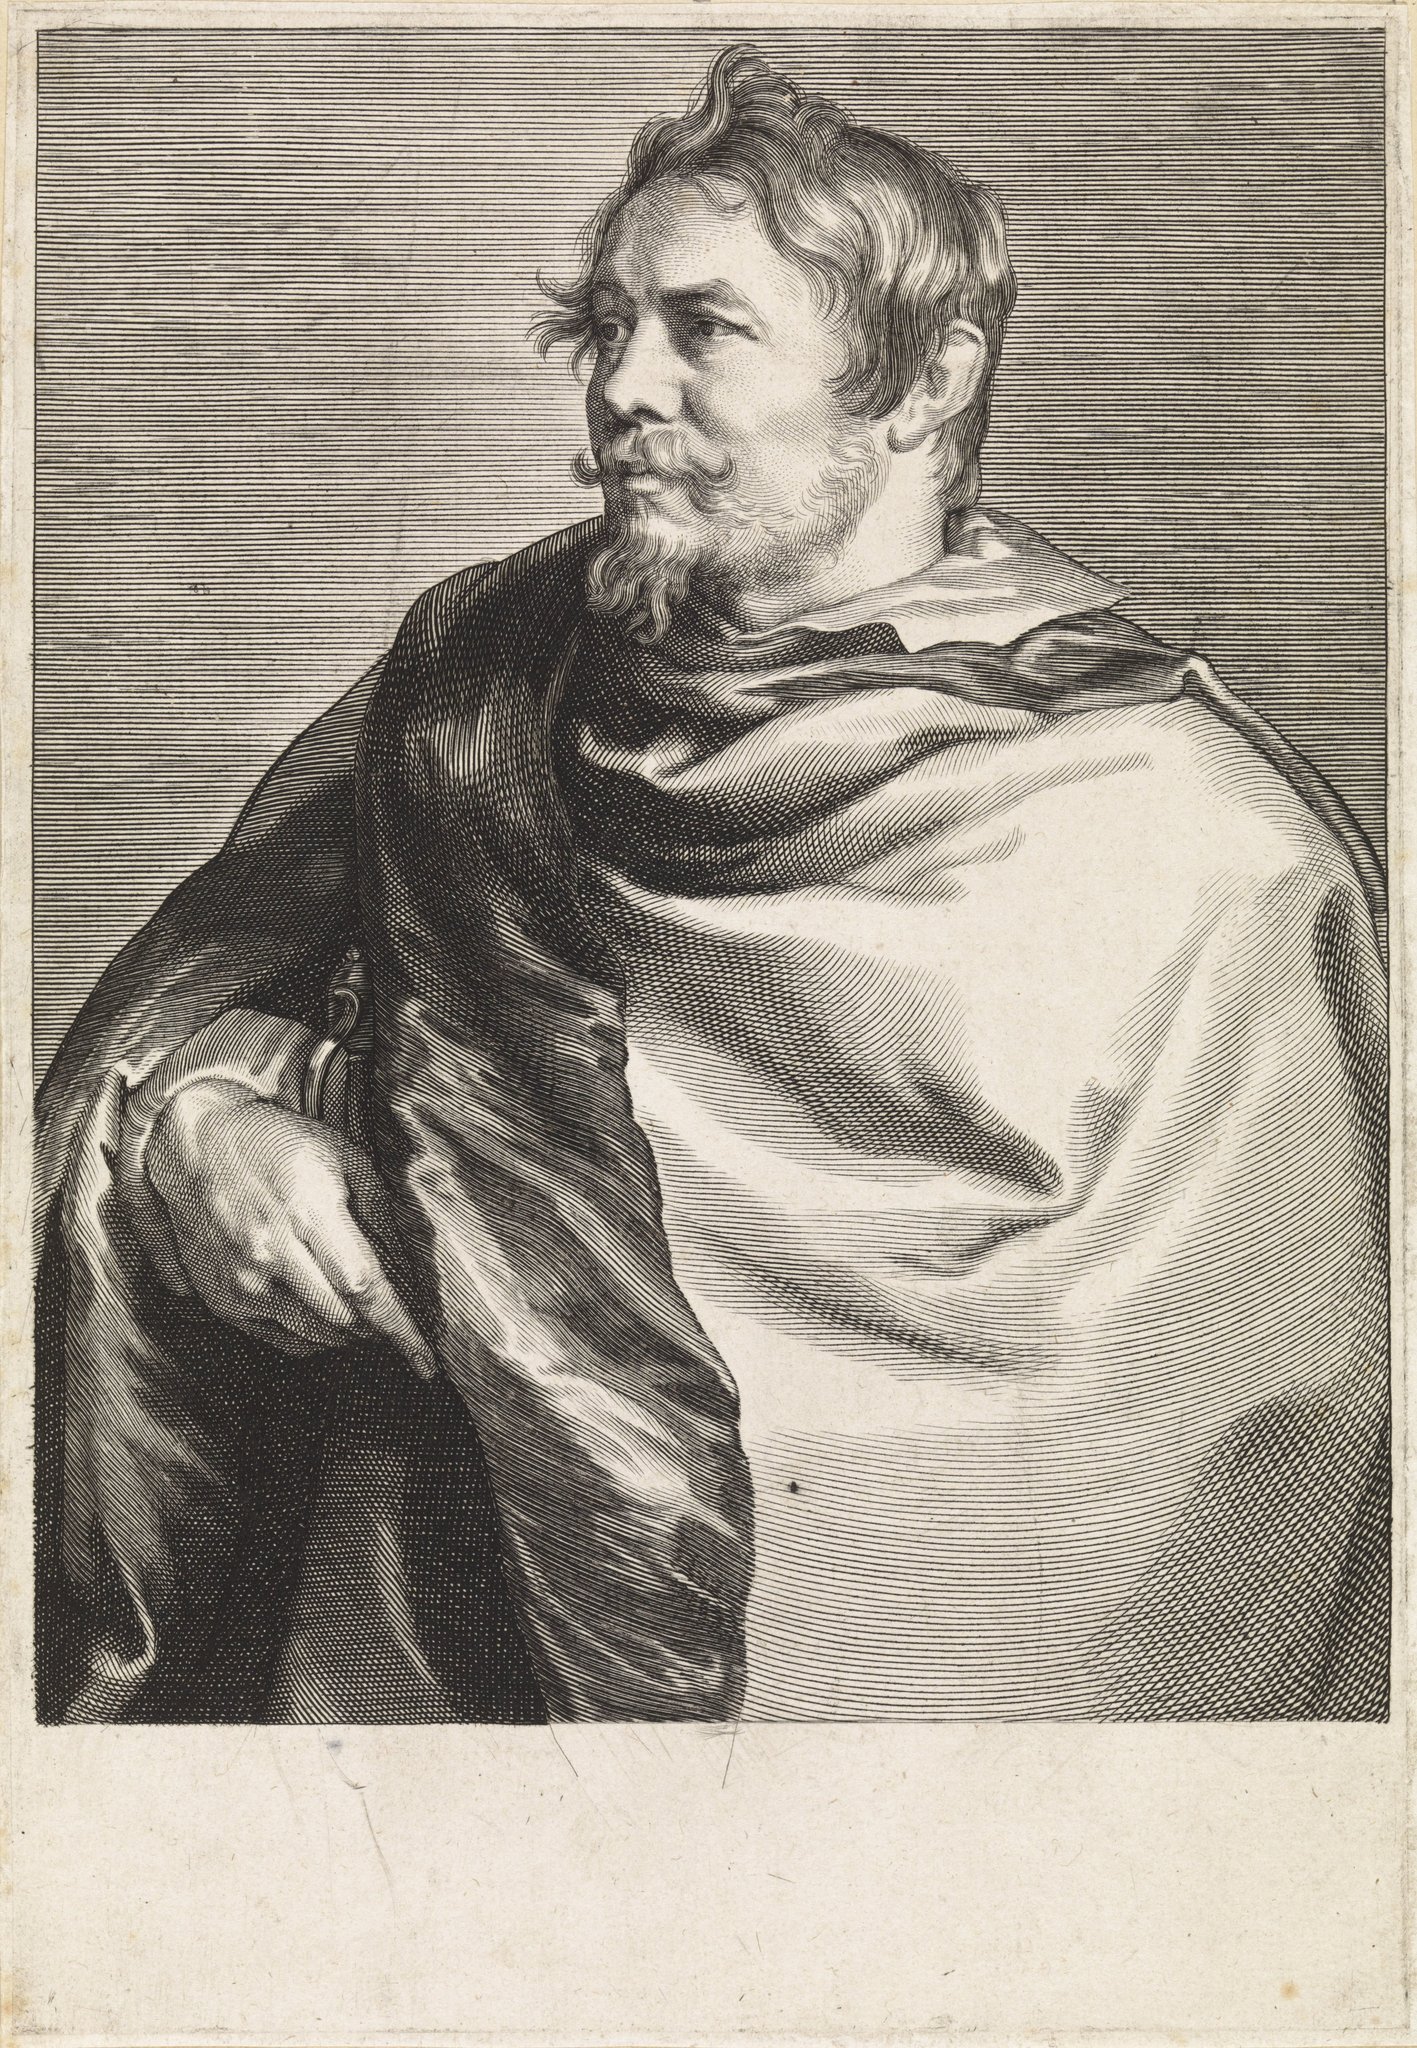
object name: print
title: Portret van de schilder Gerard Seghers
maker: paulus pontius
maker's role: draughtsman, print maker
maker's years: 1603-1658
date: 1616-1657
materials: paper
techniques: engraving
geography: antwerp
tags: painter, gerard seghers, portrait, self-portrait of painter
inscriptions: collector's mark: Lugt 240